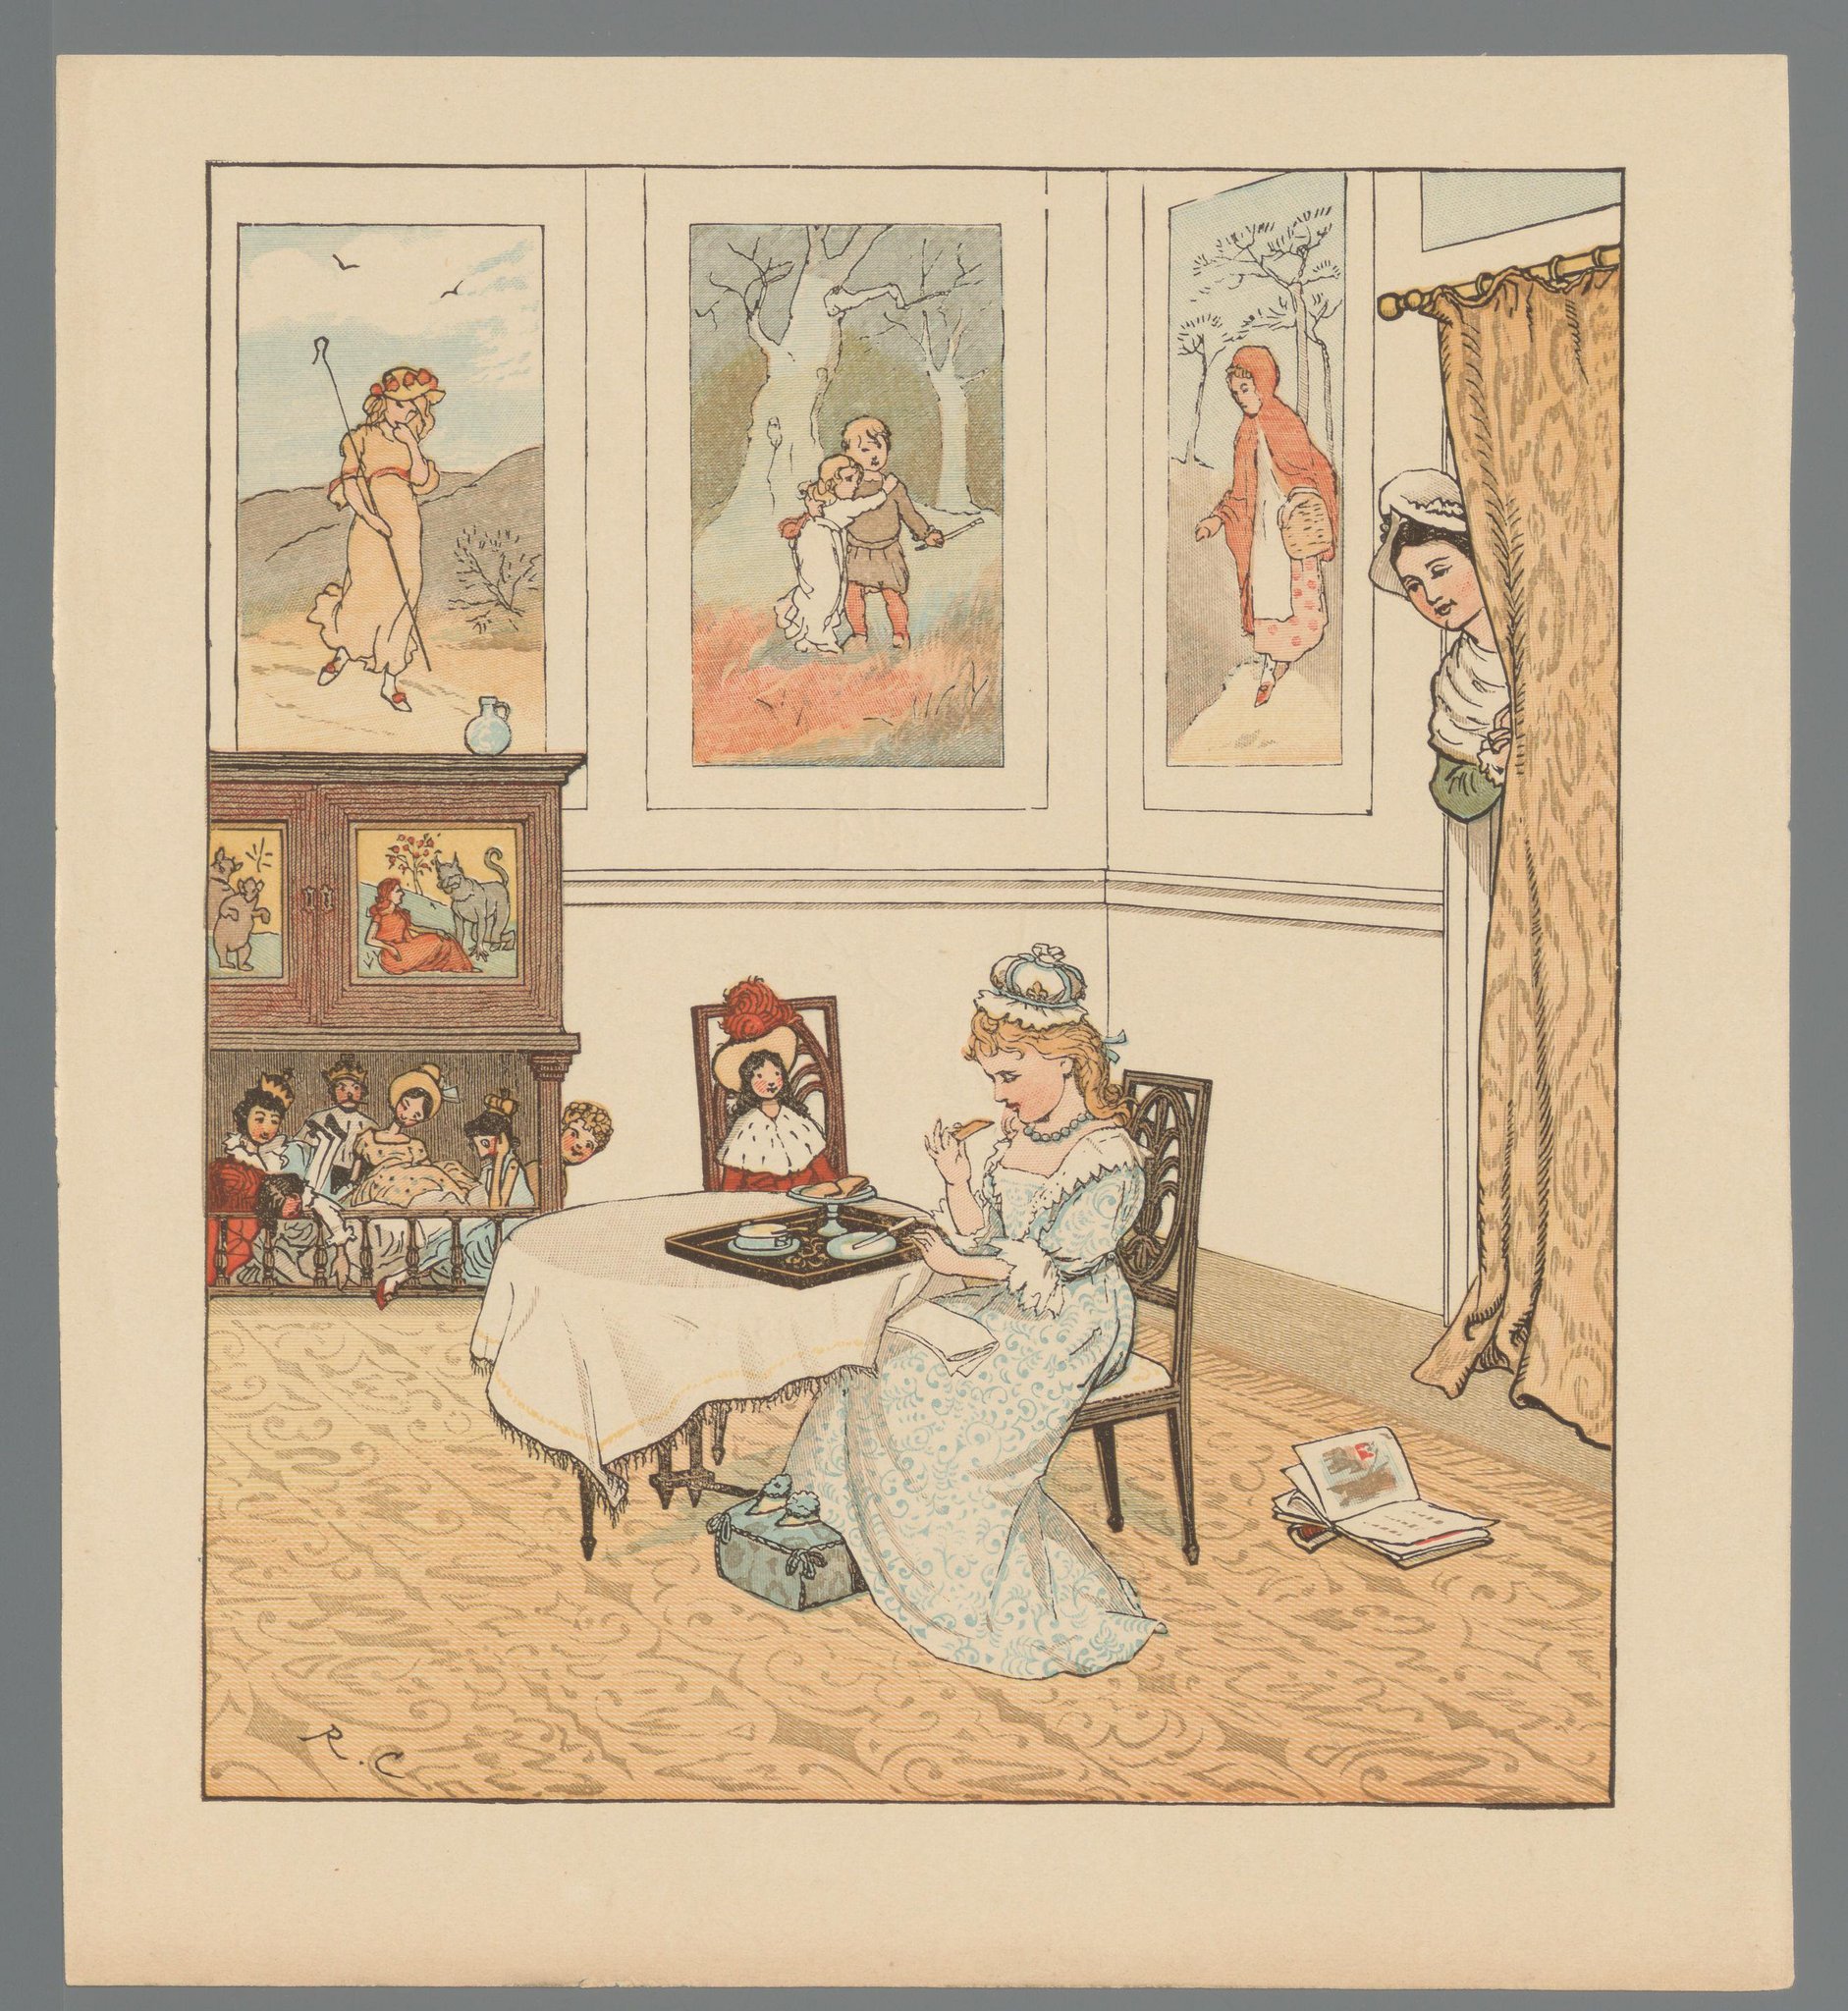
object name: book illustration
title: Interieur met koningin aan tafel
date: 1880-1927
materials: paper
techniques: wood engraving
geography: london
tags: queen, interior of the house, (playing with) dolls, eating and drinking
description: Prent uit: Sing a song of sixpence. Londen: George Routledge & Sons, 1880. Of uit een later gepubliceerde (gebundelde) uitgave.